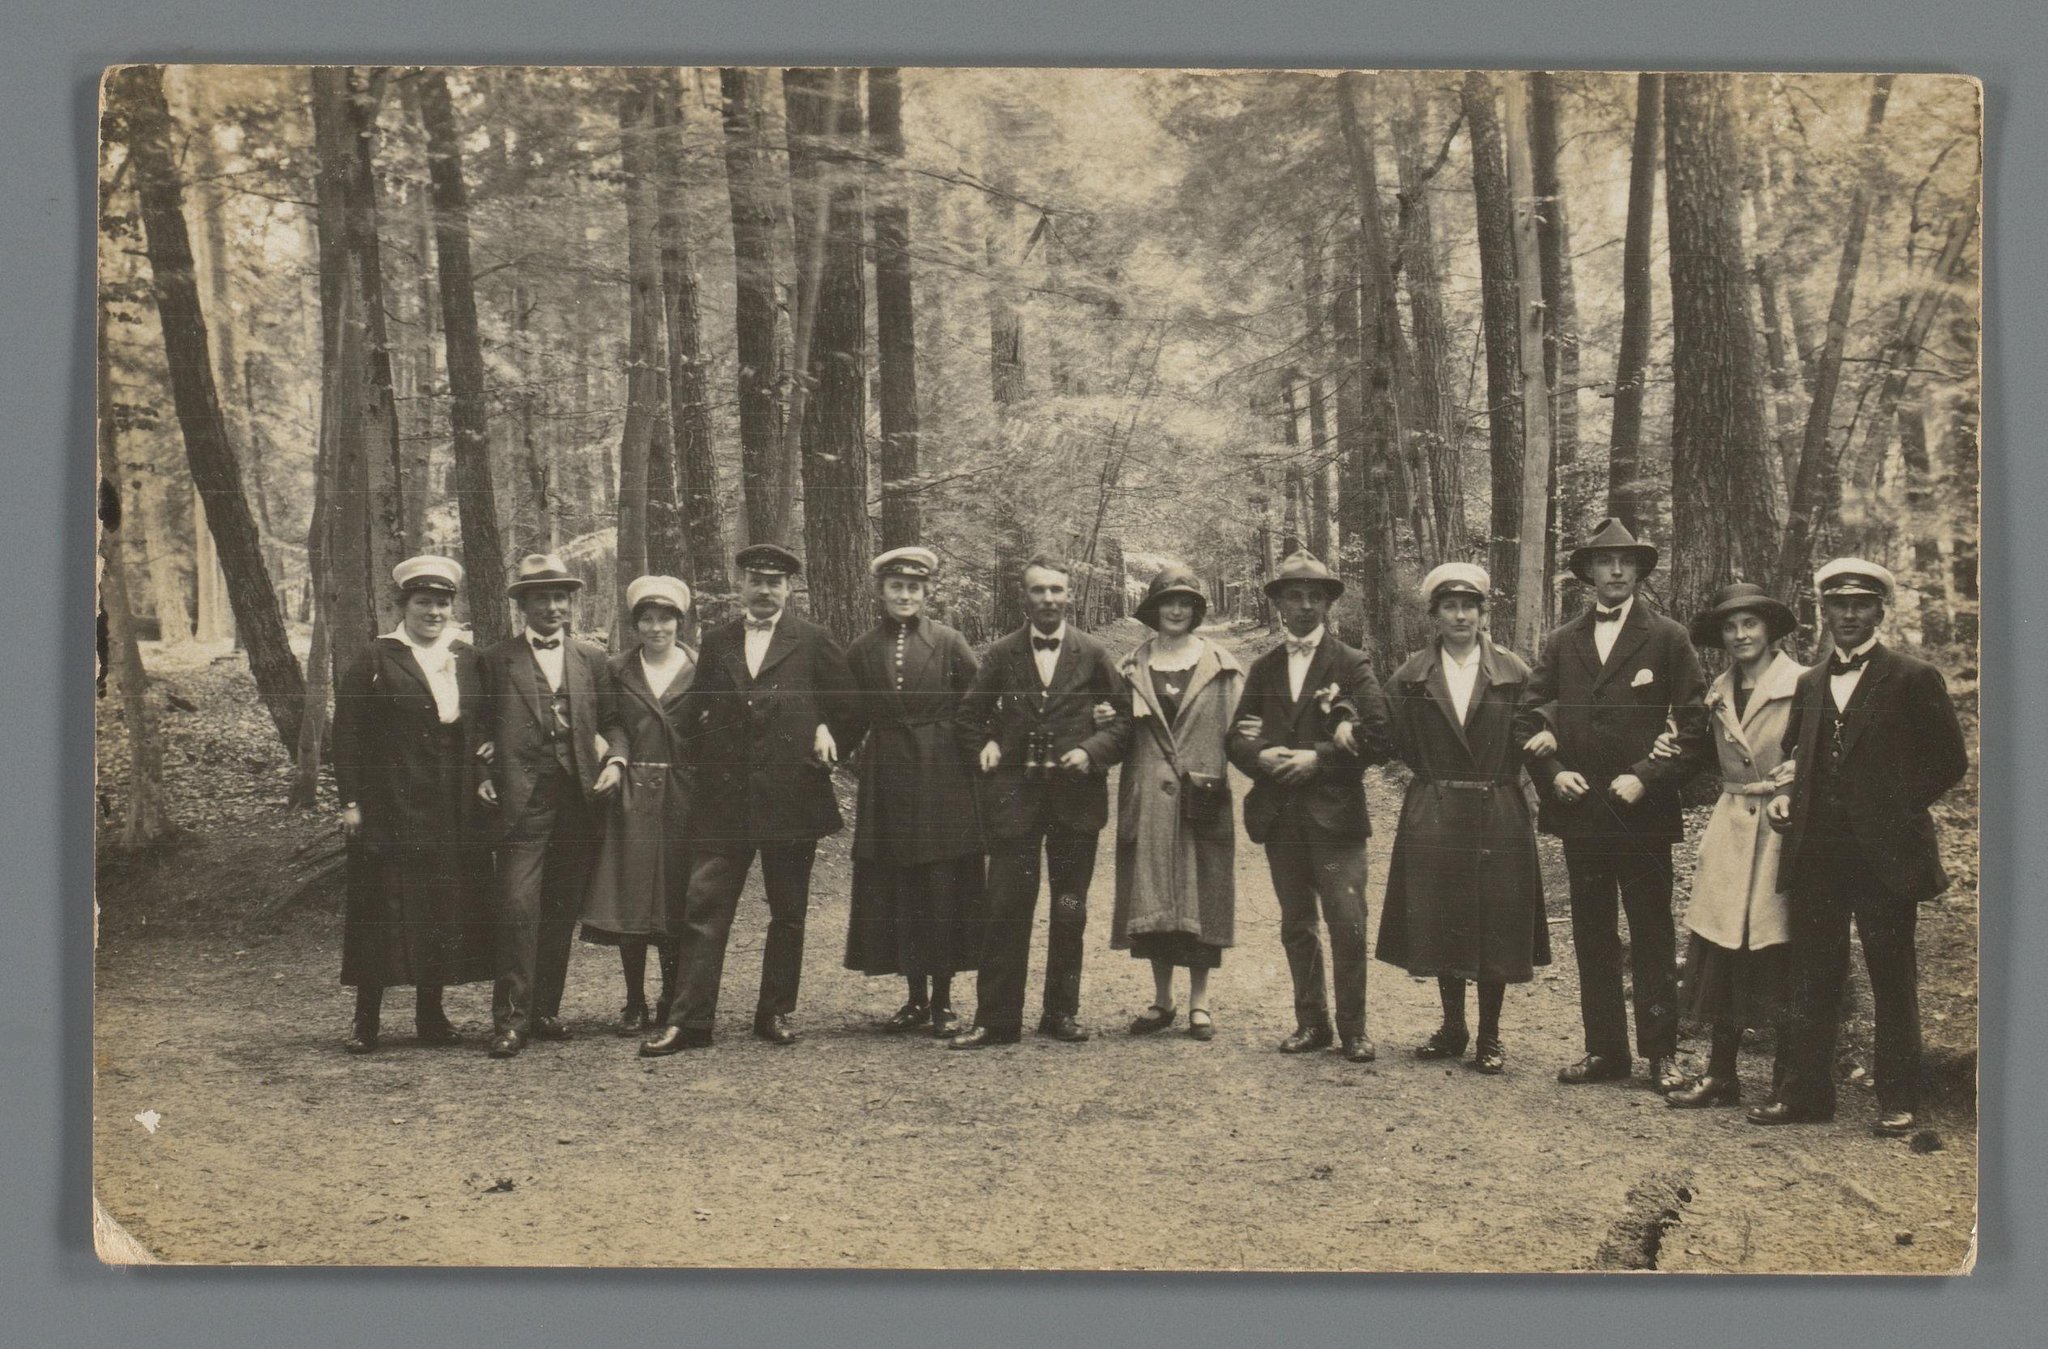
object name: photograph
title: Groepsportret van onbekende mensen in een bos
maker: Anonymous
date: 1905-1920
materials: paper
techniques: gelatin silver print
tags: arm in arm (friends), forest, wood, anonymous historical persons portrayed in a group, in a group-portrait